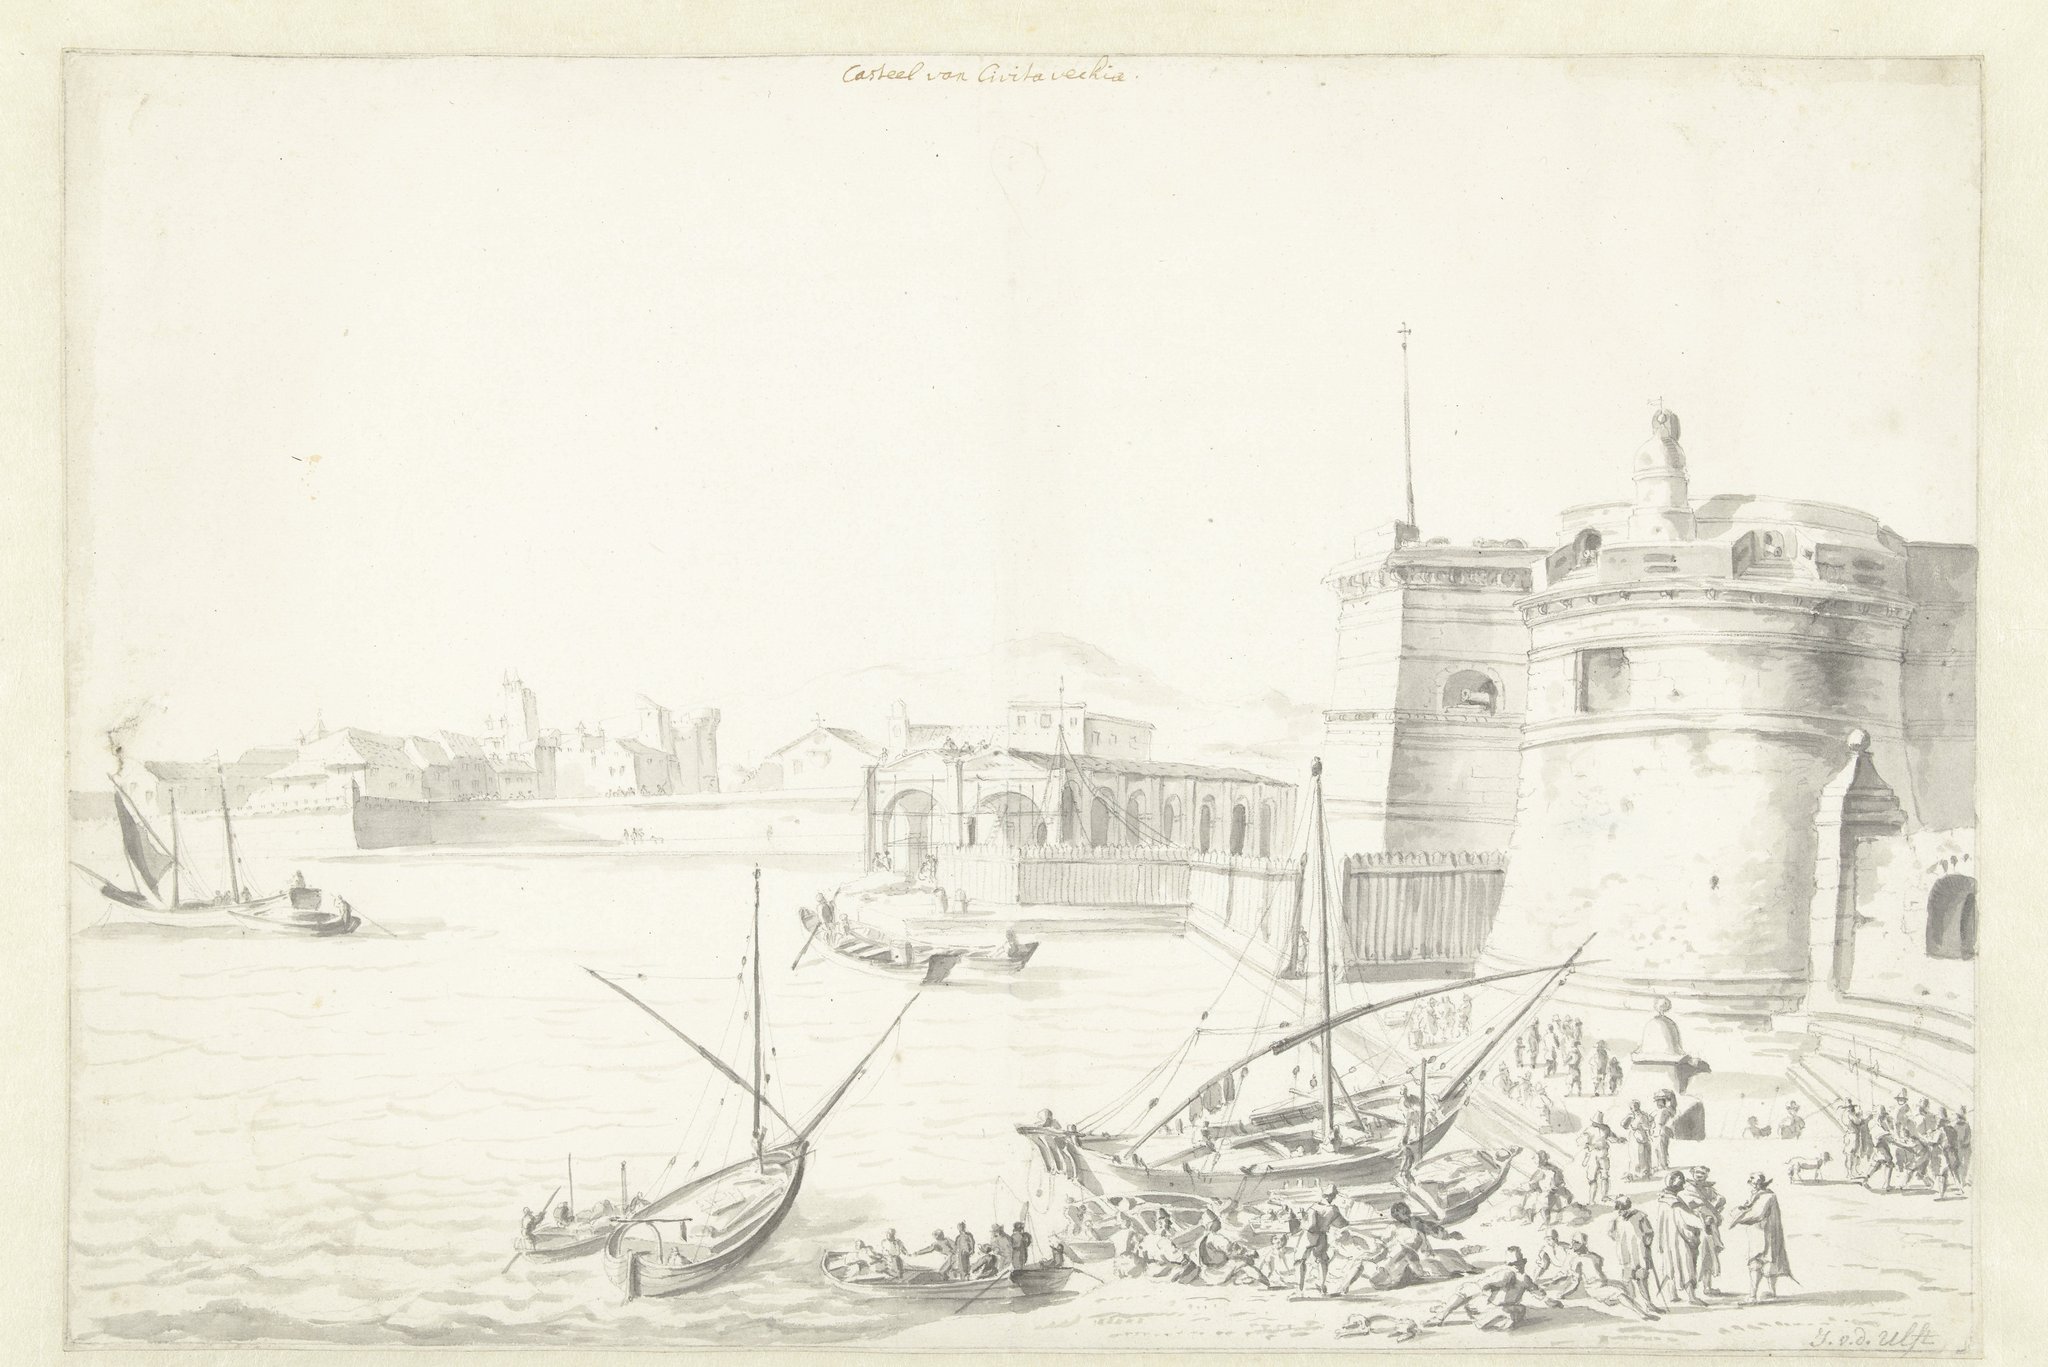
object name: drawing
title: Gezicht op het kasteel van Civitavecchia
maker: jacob van der ulft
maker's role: draughtsman, painter, print maker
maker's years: 1627-1689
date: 1660-1689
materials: chalk, paper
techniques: brush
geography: civitavecchia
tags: harbour, fortress, castle, quay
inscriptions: annotation: ‘Casteel van Civitavechia’, signature: ‘J. v.d. Ulft’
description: De haven en het kasteel van Civitavecchia.